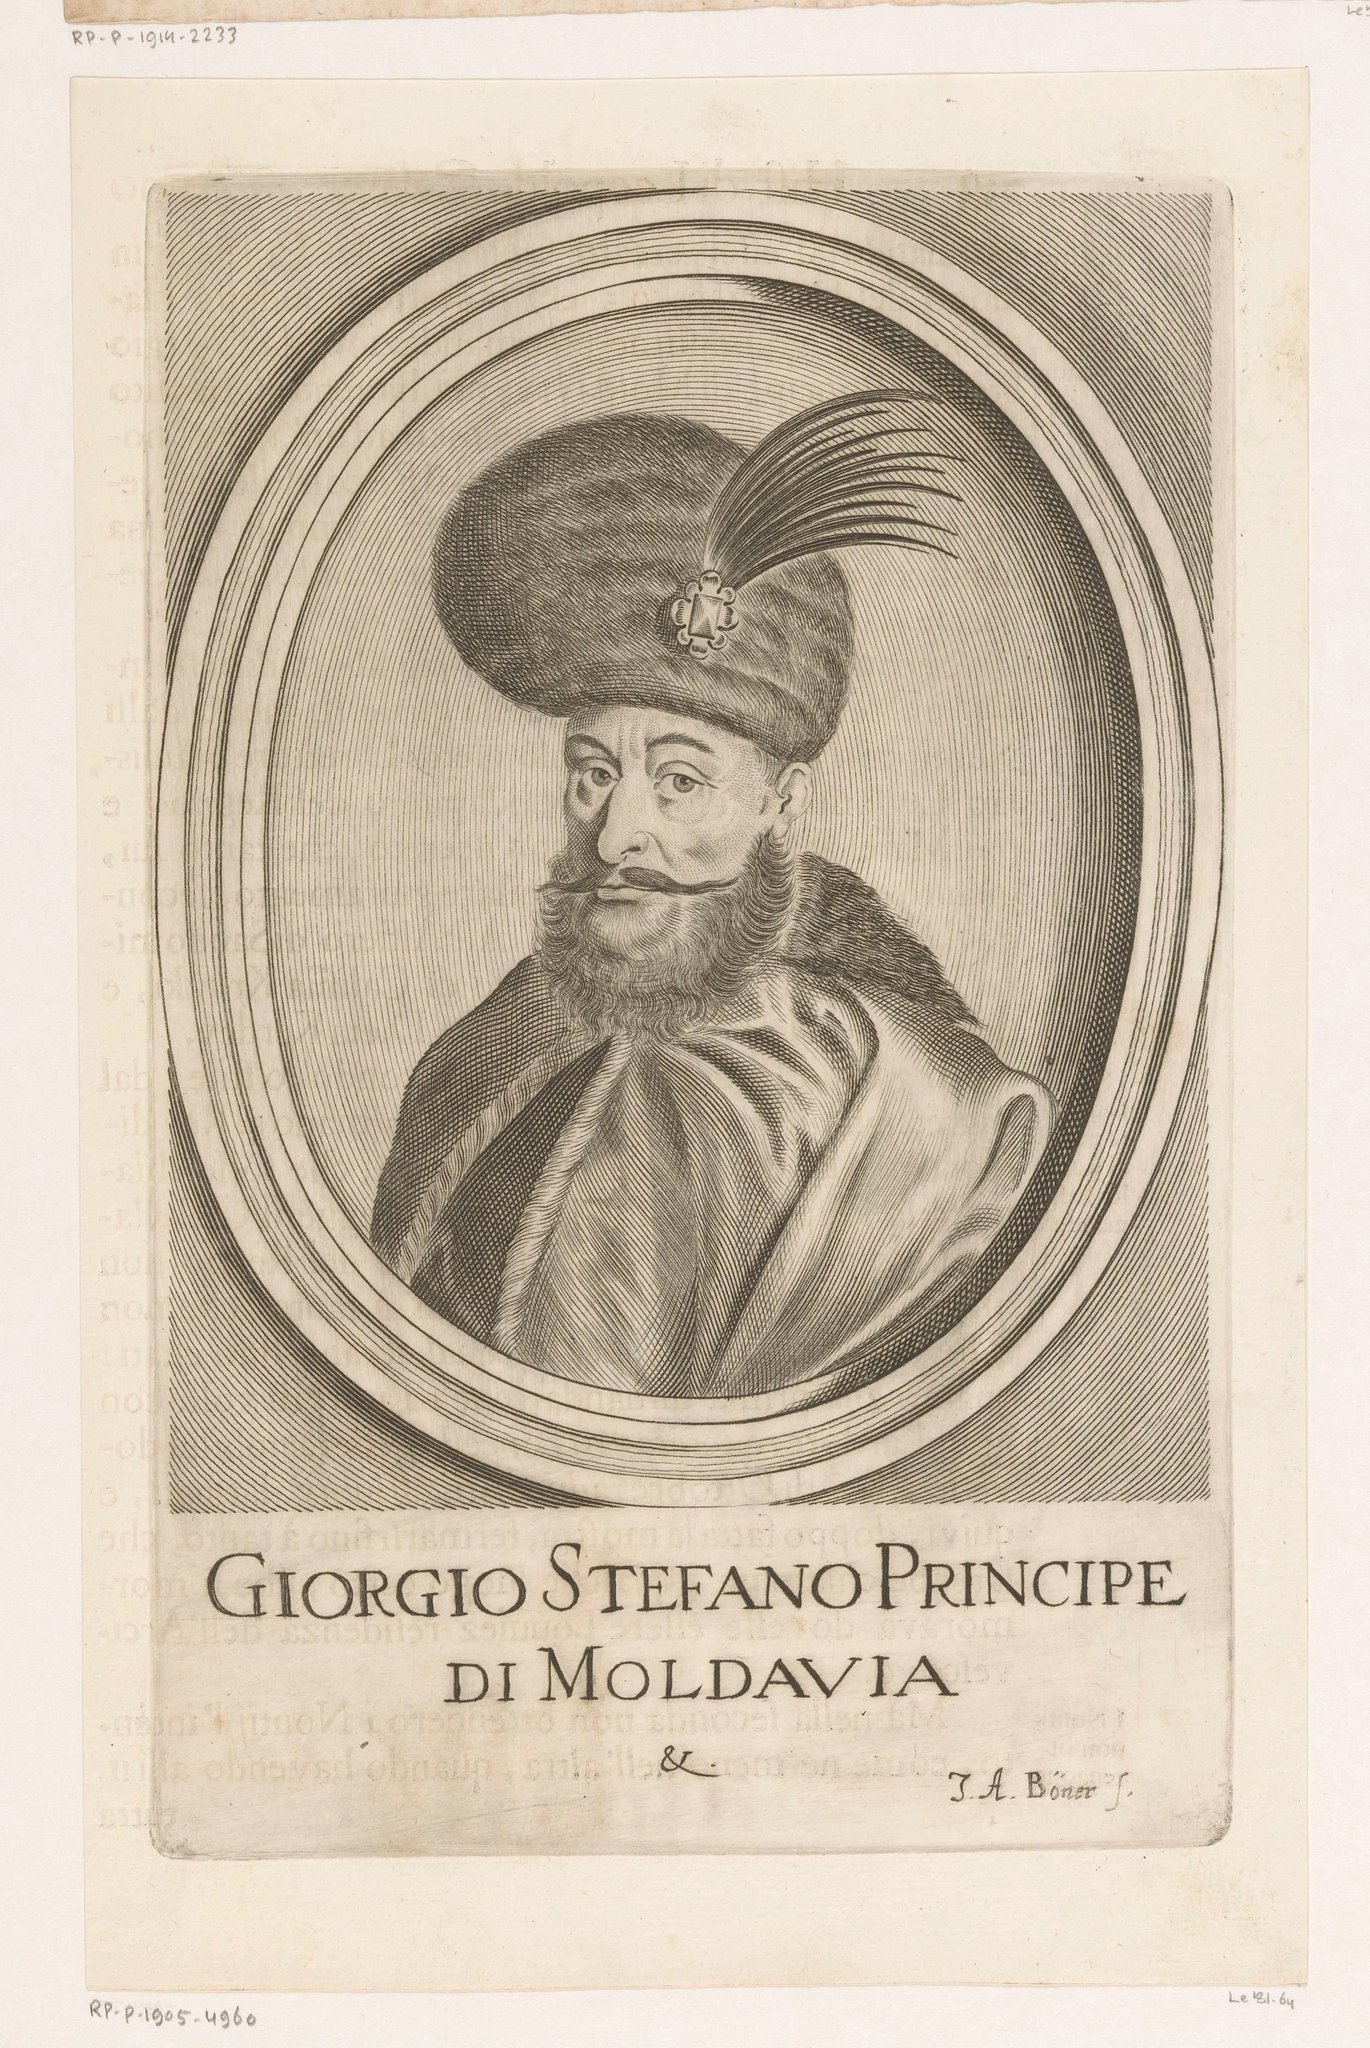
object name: print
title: Portret van Gheorghe Duca, prins van Moldavië en Walachije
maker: johann alexander böner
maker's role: draughtsman, print maker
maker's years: 1647-1720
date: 1674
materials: paper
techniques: engraving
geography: nuremberg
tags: historical persons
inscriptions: collector's mark: Lugt 2228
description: Prent ook gebruikt in: Gualdo Priorato, Galeazzo. Historia di Leopoldo Cesare. 3 dln. Wenen: Johann Baptist Hacque, 1670-1674, dl. 3 [1674], na p. 738.